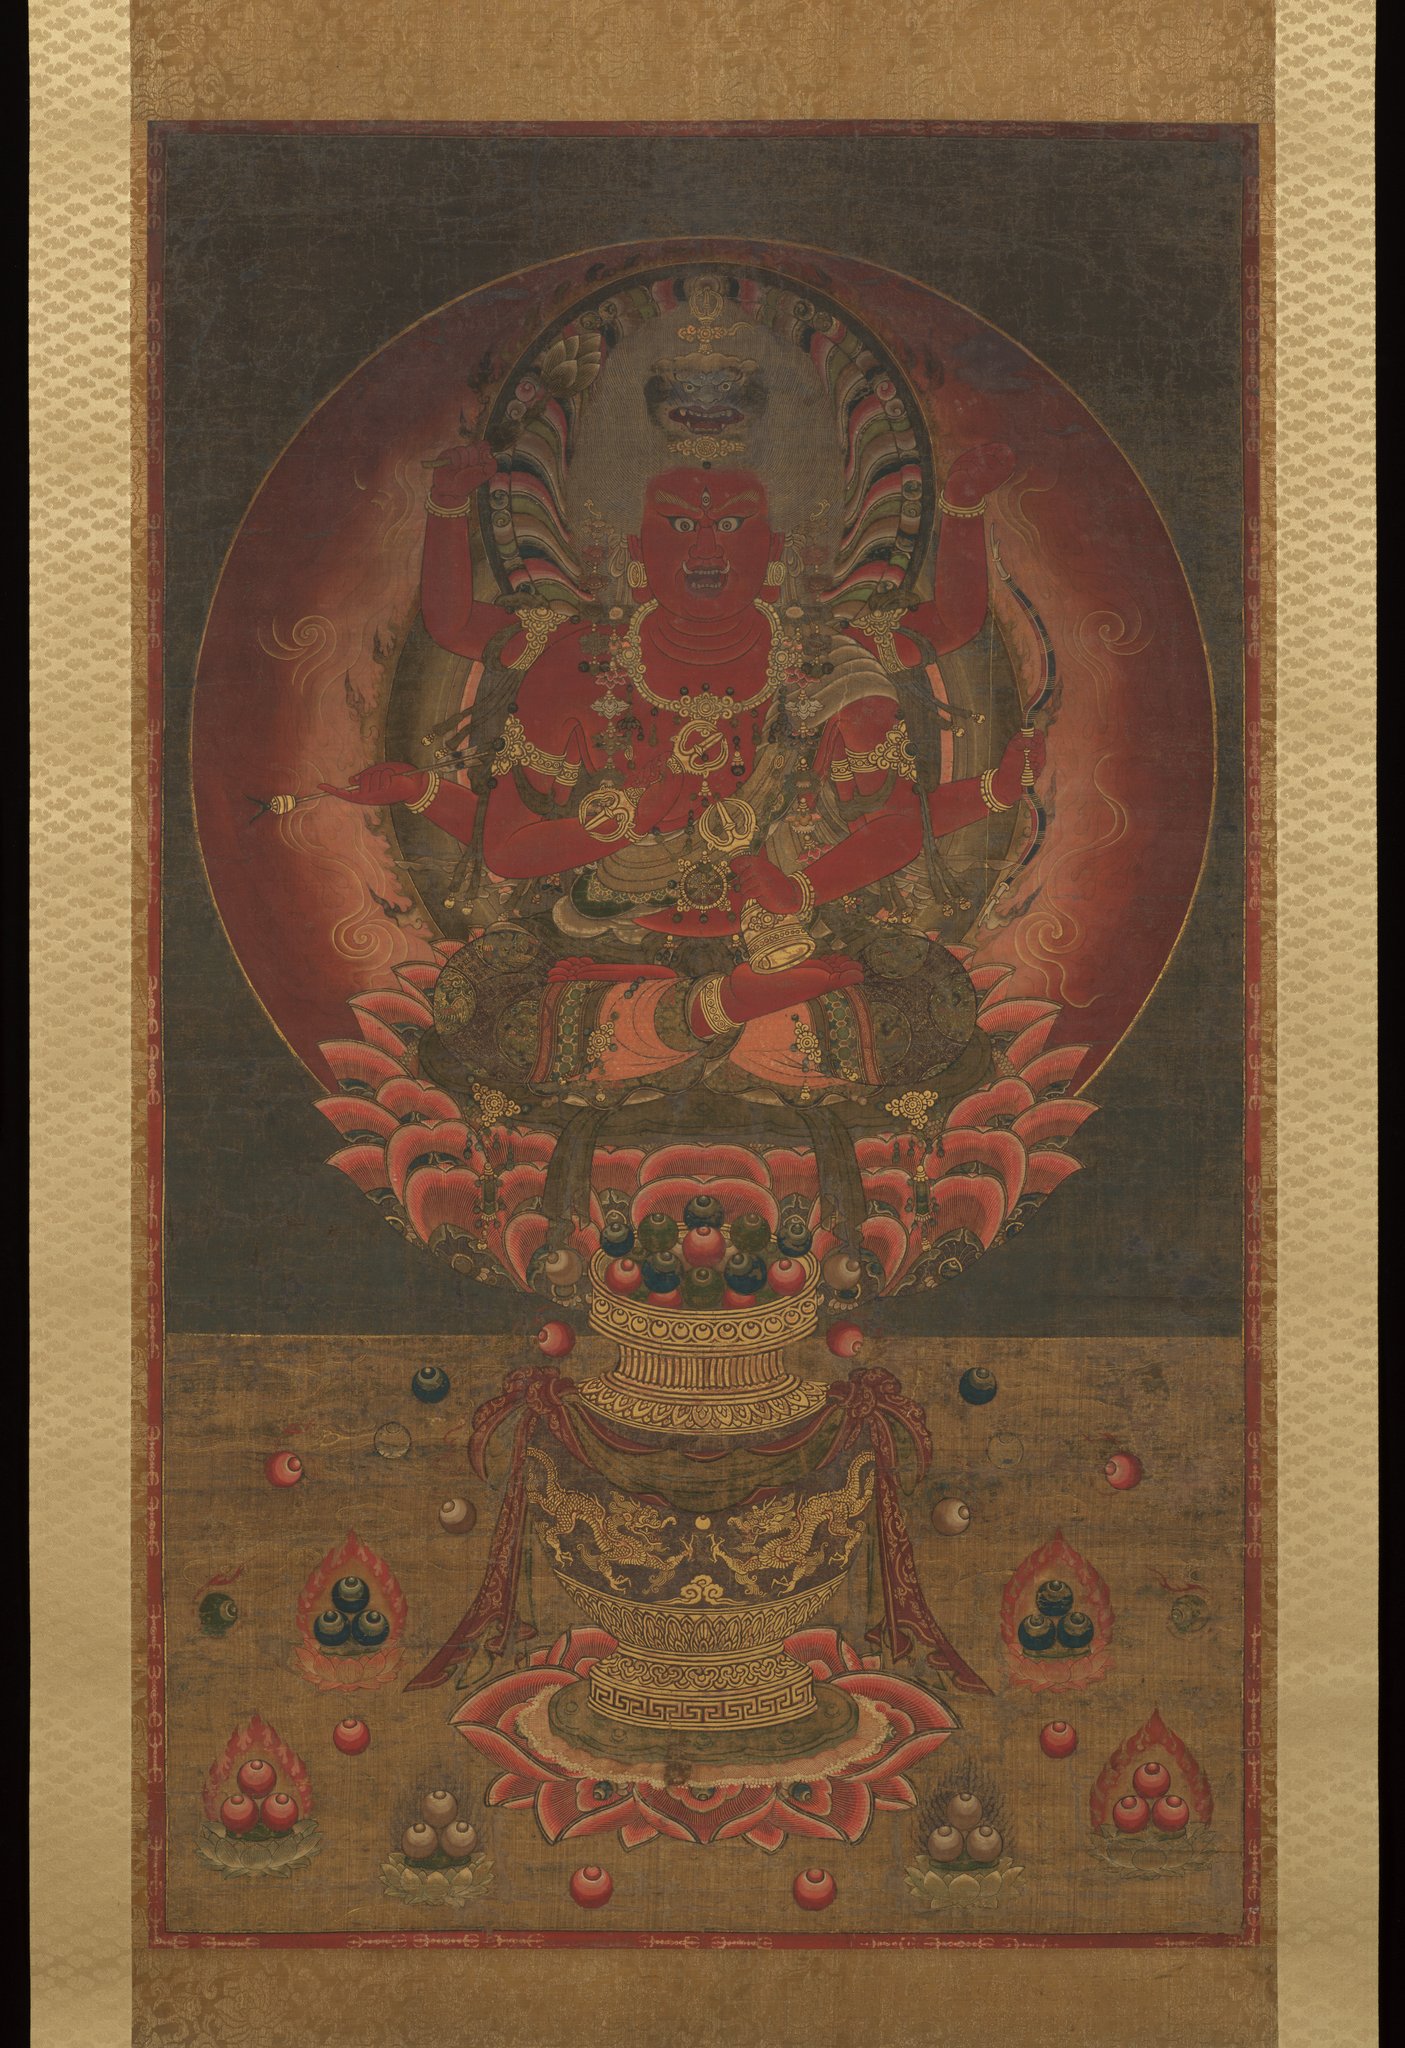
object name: hanging scroll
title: The Wisdom King Aizen (Aizen Myōō)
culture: japanese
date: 1301-1400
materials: gold, gold leaf, ink, silk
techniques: cutting, kirikane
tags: bow and arrow,buddhism,deities